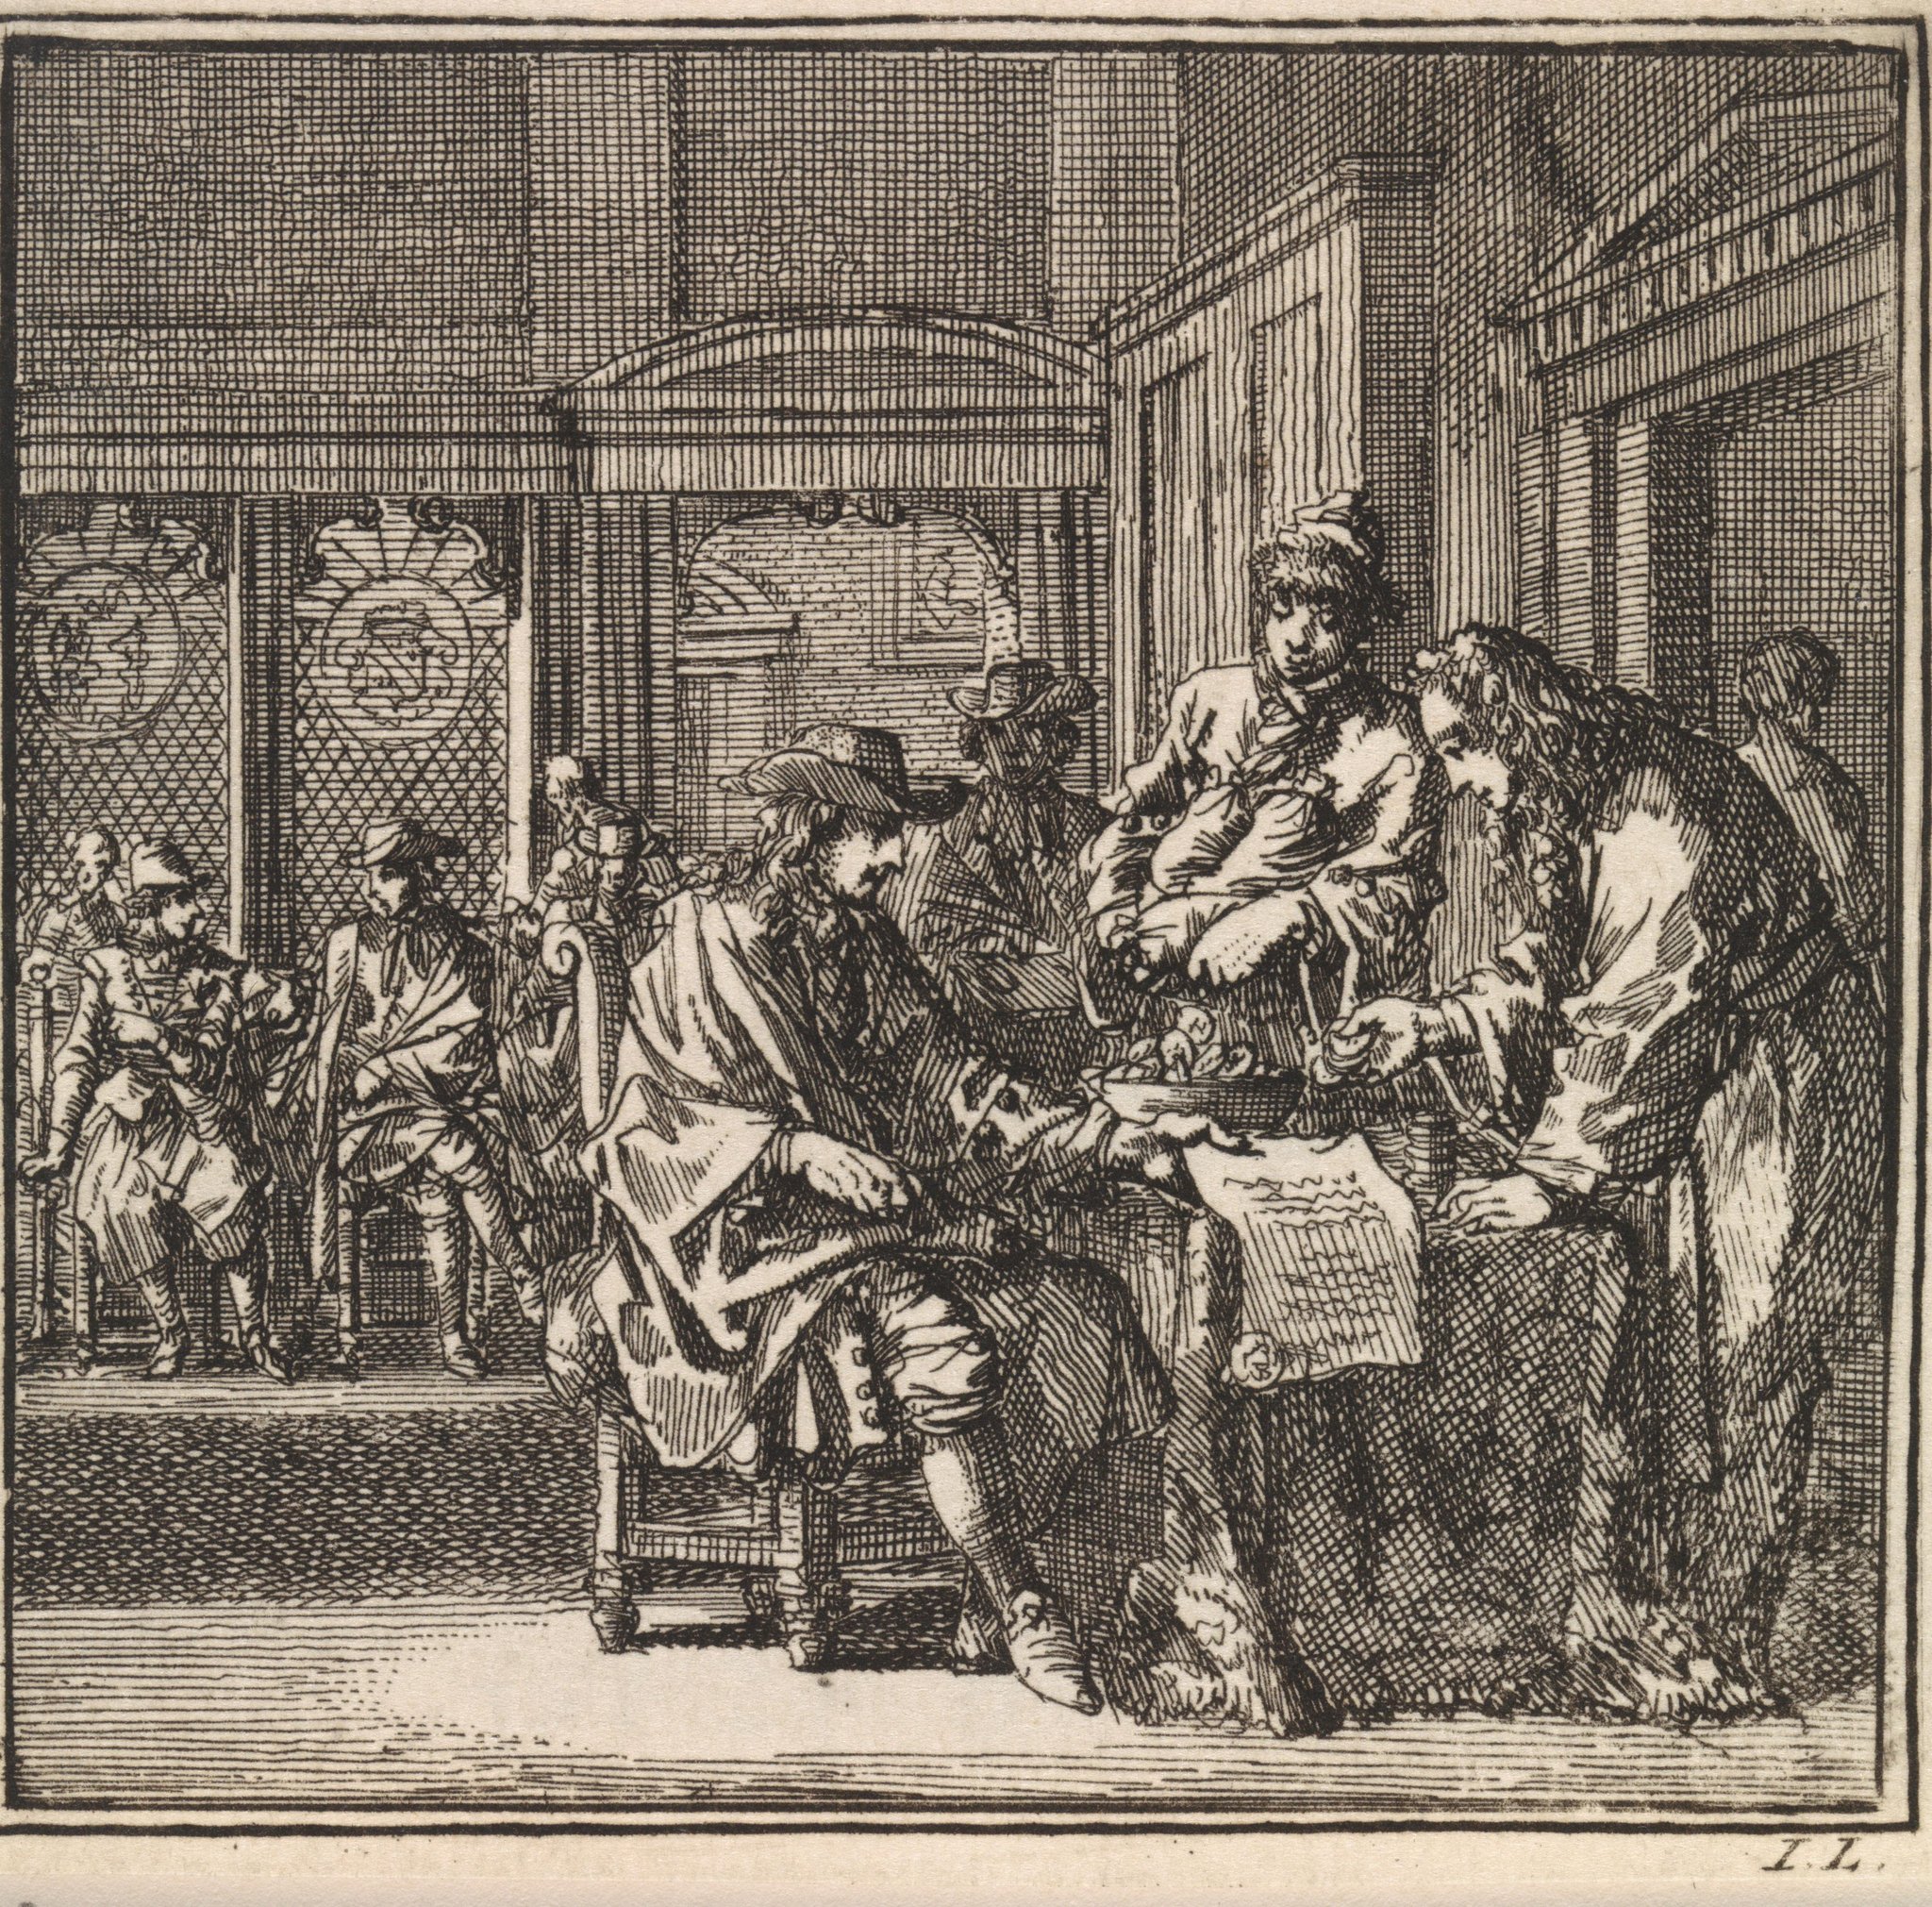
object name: book illustration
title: In een vertrek houden enkele mannen zich met geld bezig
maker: jan luyken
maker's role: draughtsman, print maker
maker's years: 1649-1712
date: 1711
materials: paper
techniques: etching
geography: amsterdam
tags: dealing in money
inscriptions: collector's mark: Lugt 2228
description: Illustratie voor: Luyken, Jan. De Bykorf des Gemoeds. Amsterdam: Pieter Arentsz. II (wed.) en Cornelis van der Sys, 1711, p. 338.